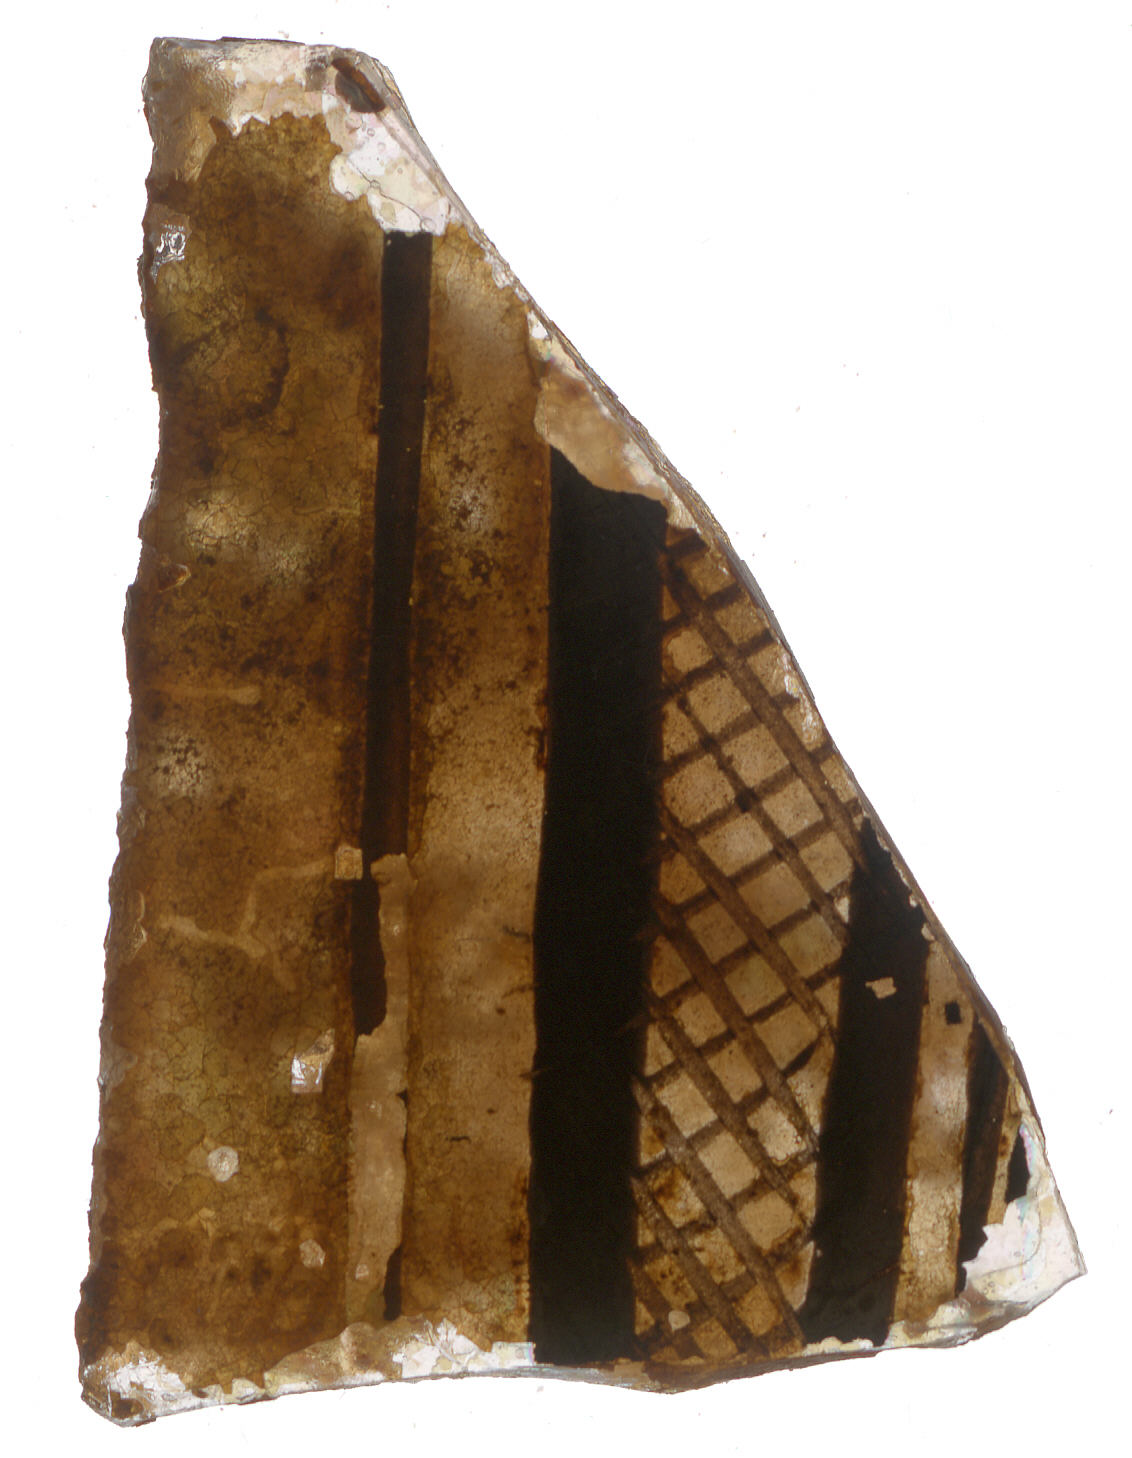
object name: fragment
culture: crusader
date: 1201-1300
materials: glass